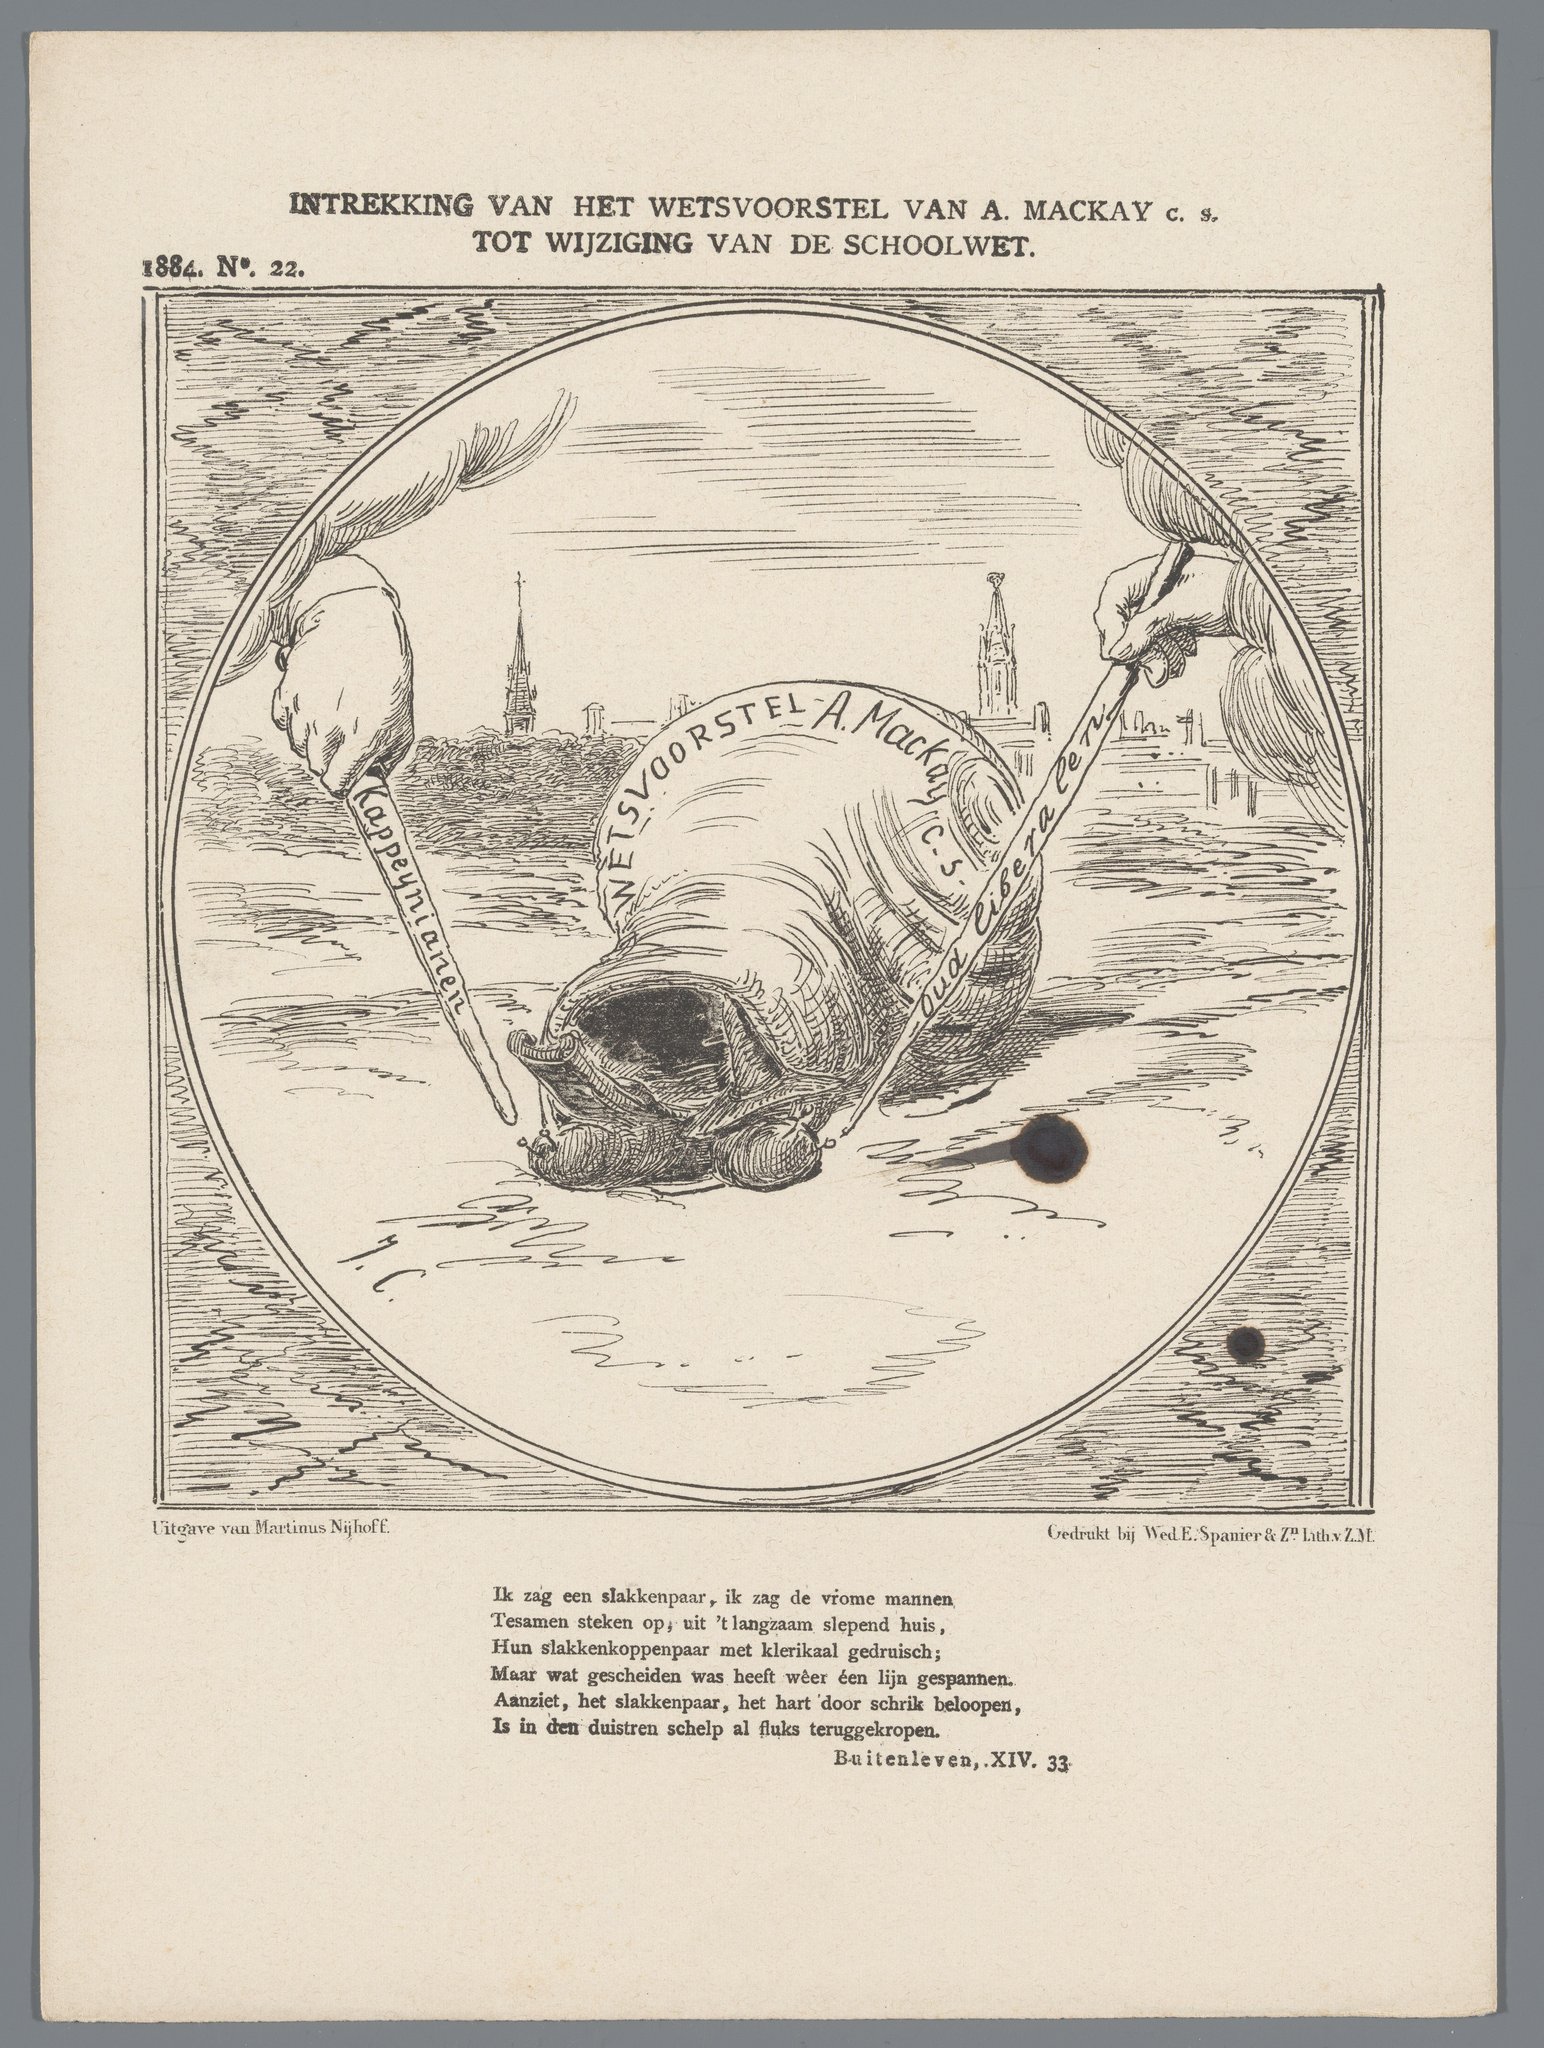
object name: cartoon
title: Spotprent over de schoolwet, 1884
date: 1884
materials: paper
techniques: lithograph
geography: the hague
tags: nijmegen, molluscs: snail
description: Spotprent over kamerlid Mackay en de schoolwet: een slak met twee koppen. Plaat verschenen bij het weekblad De Nederlandsche Spectator, nr. 22, 1884.